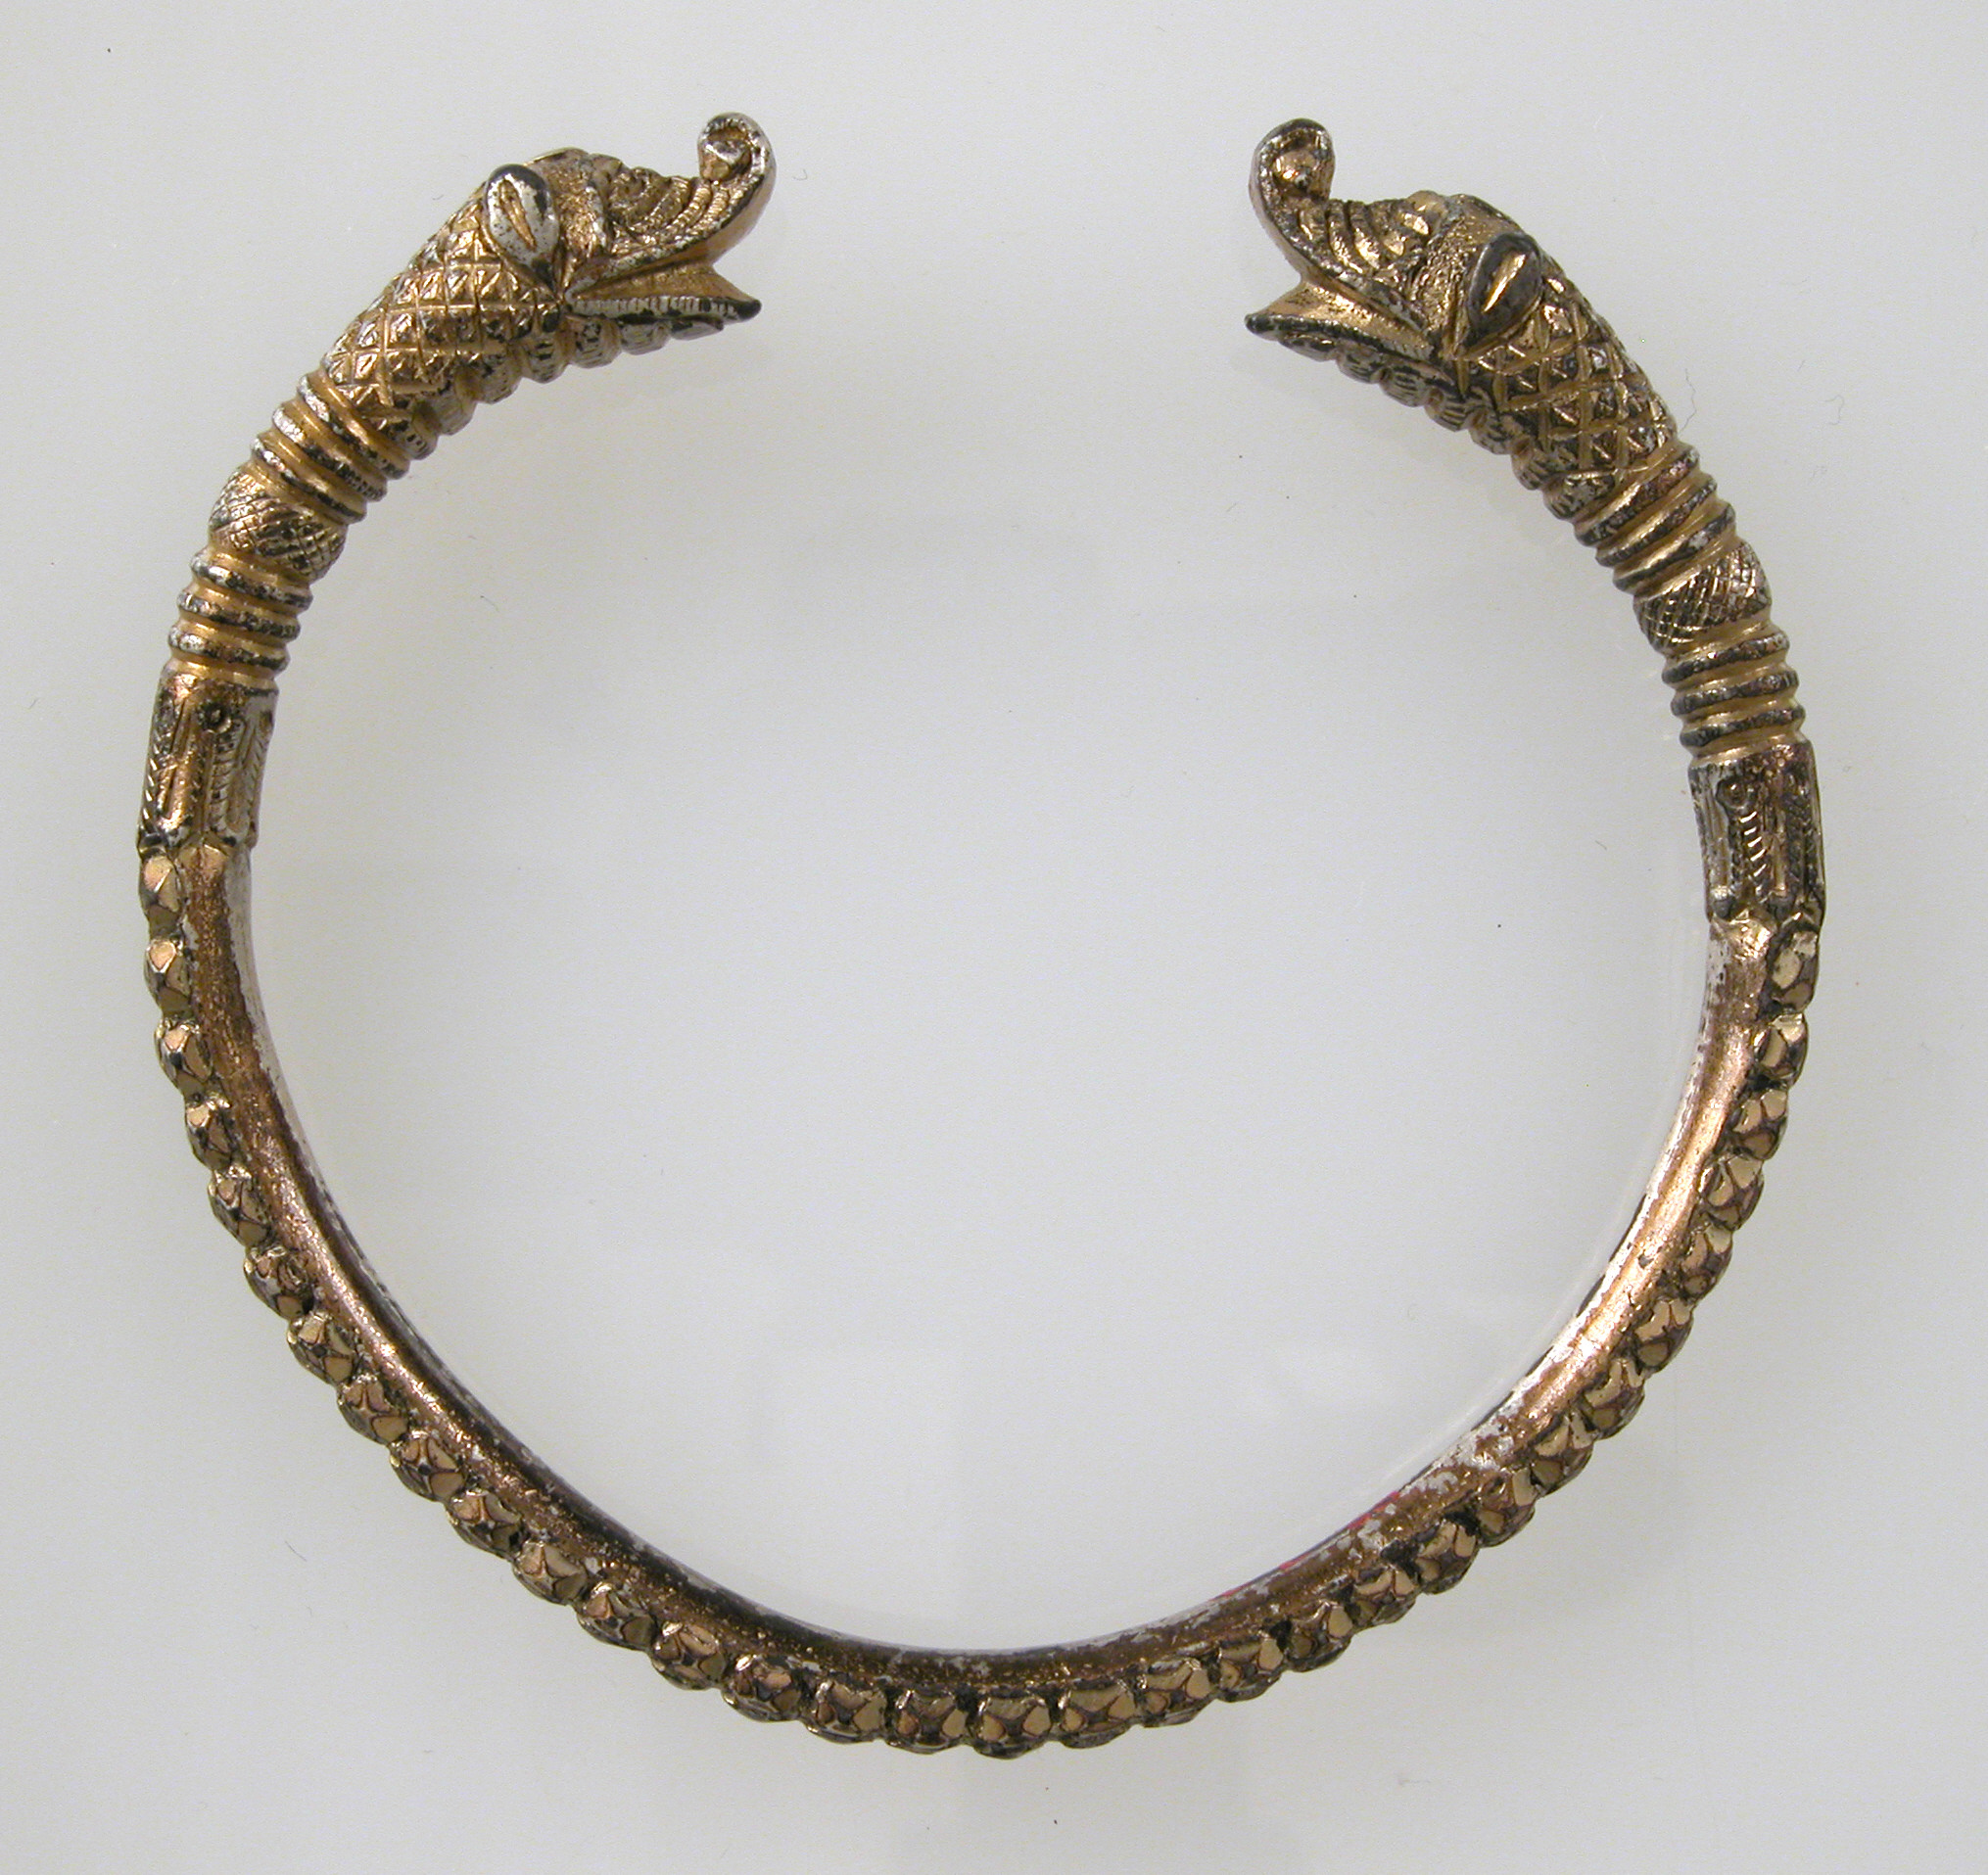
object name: bracelet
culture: indian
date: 1801-1900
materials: silver gilt